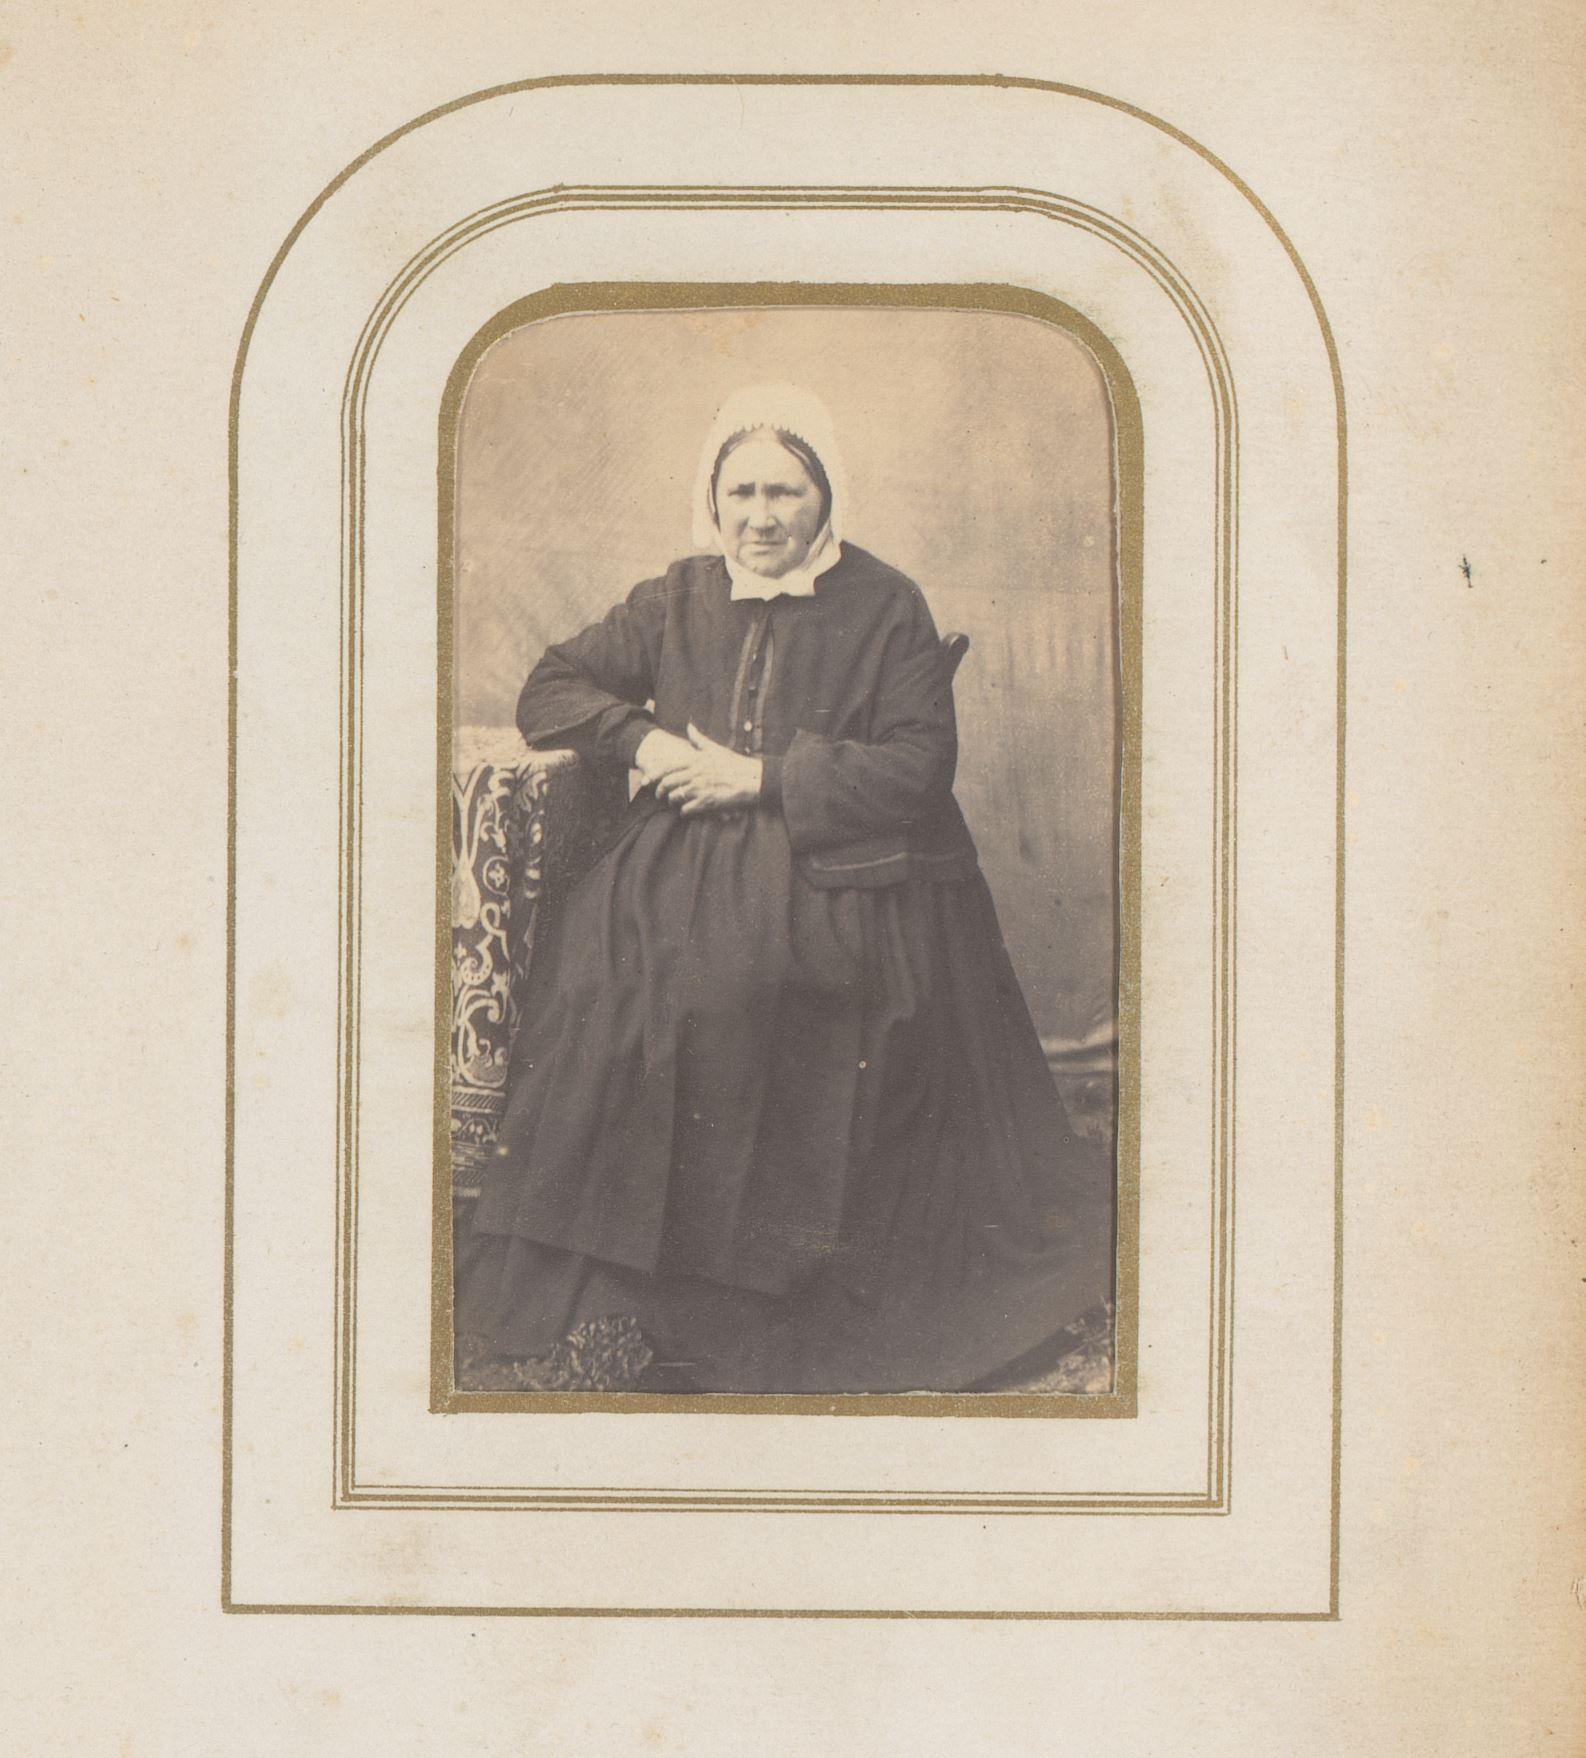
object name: carte de visite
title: Portret van een zittende oude vrouw met muts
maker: Anonymous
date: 1860-1880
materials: cardboard, photographic support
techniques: albumen print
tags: historical persons - bb - woman, head-gear: hat